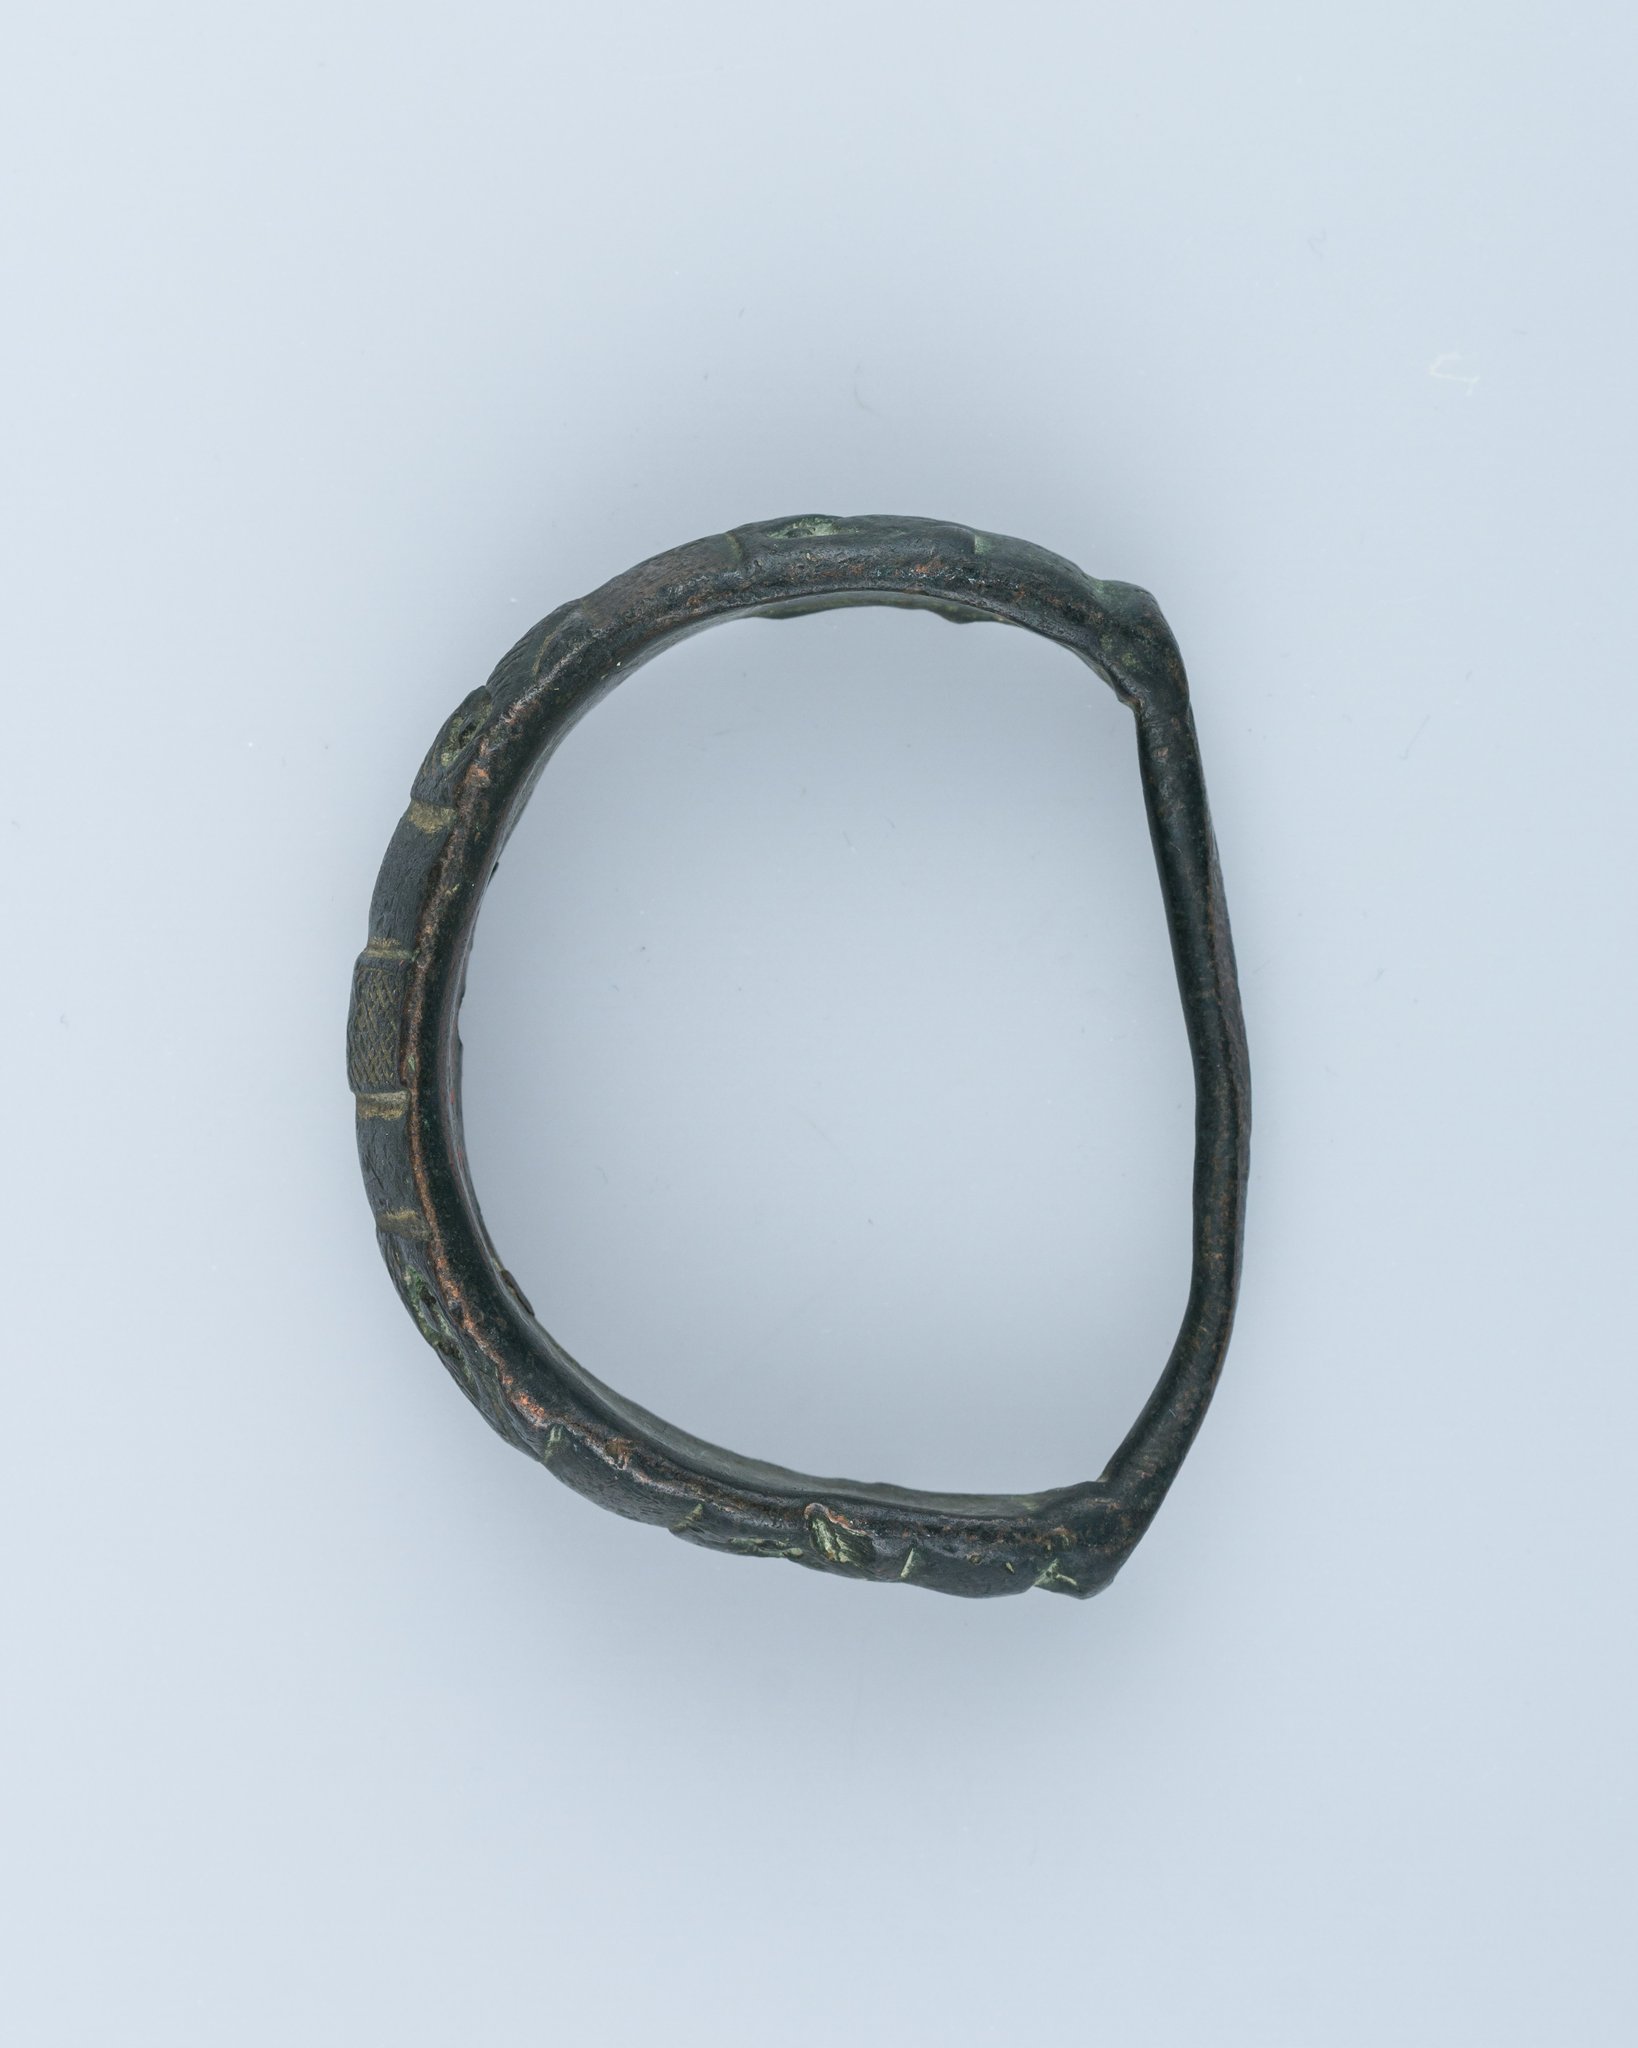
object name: buckle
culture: ibero-roman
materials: bronze, patina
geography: spain or portugal